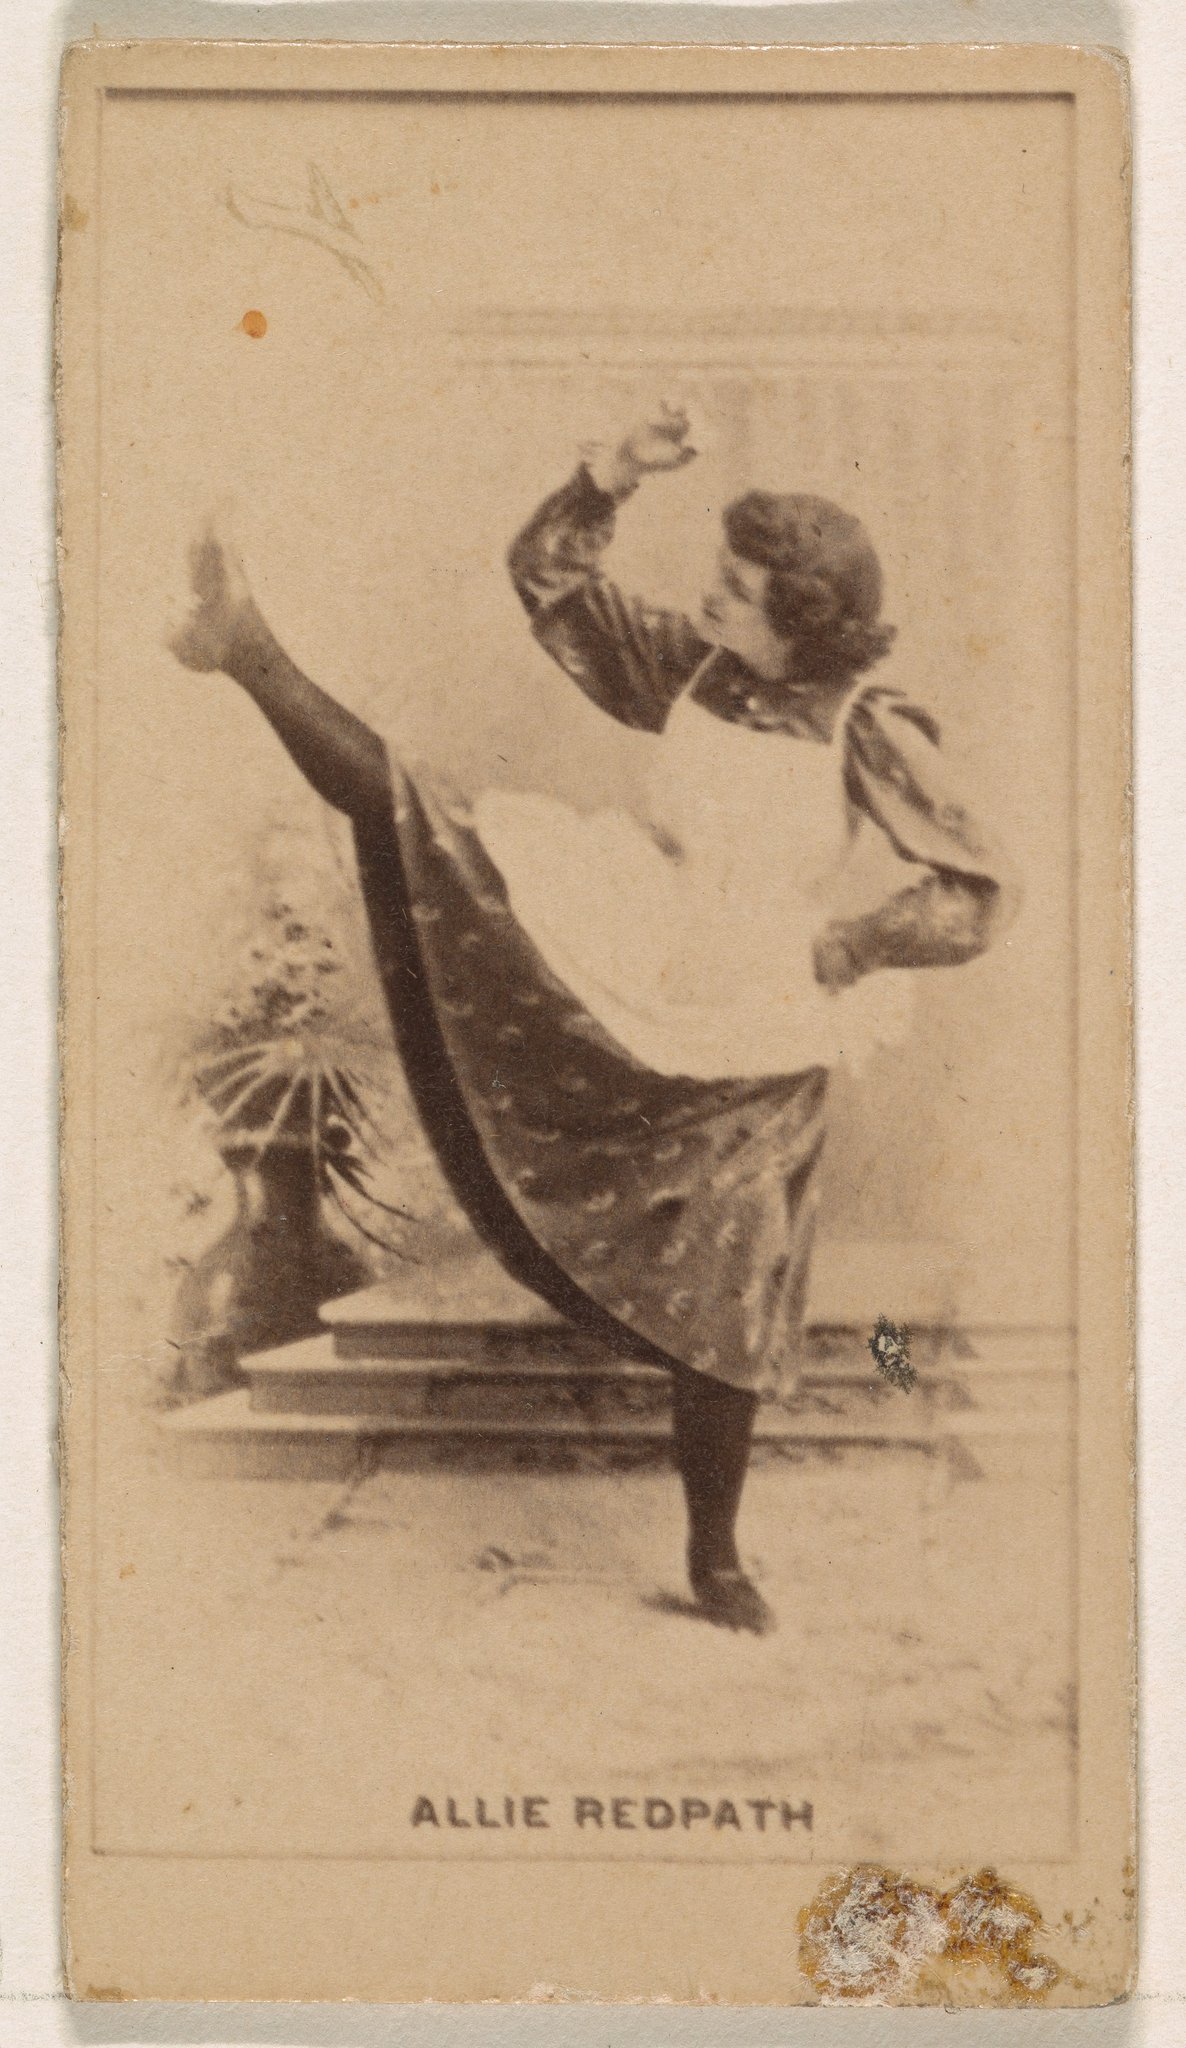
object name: photograph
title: Allie Redpath, from the Actresses series (N245) issued by Kinney Brothers to promote Sweet Caporal Cigarettes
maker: kinney brothers tobacco company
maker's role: publisher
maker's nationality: american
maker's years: 1869-2011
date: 1890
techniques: albumen silver print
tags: women,actresses